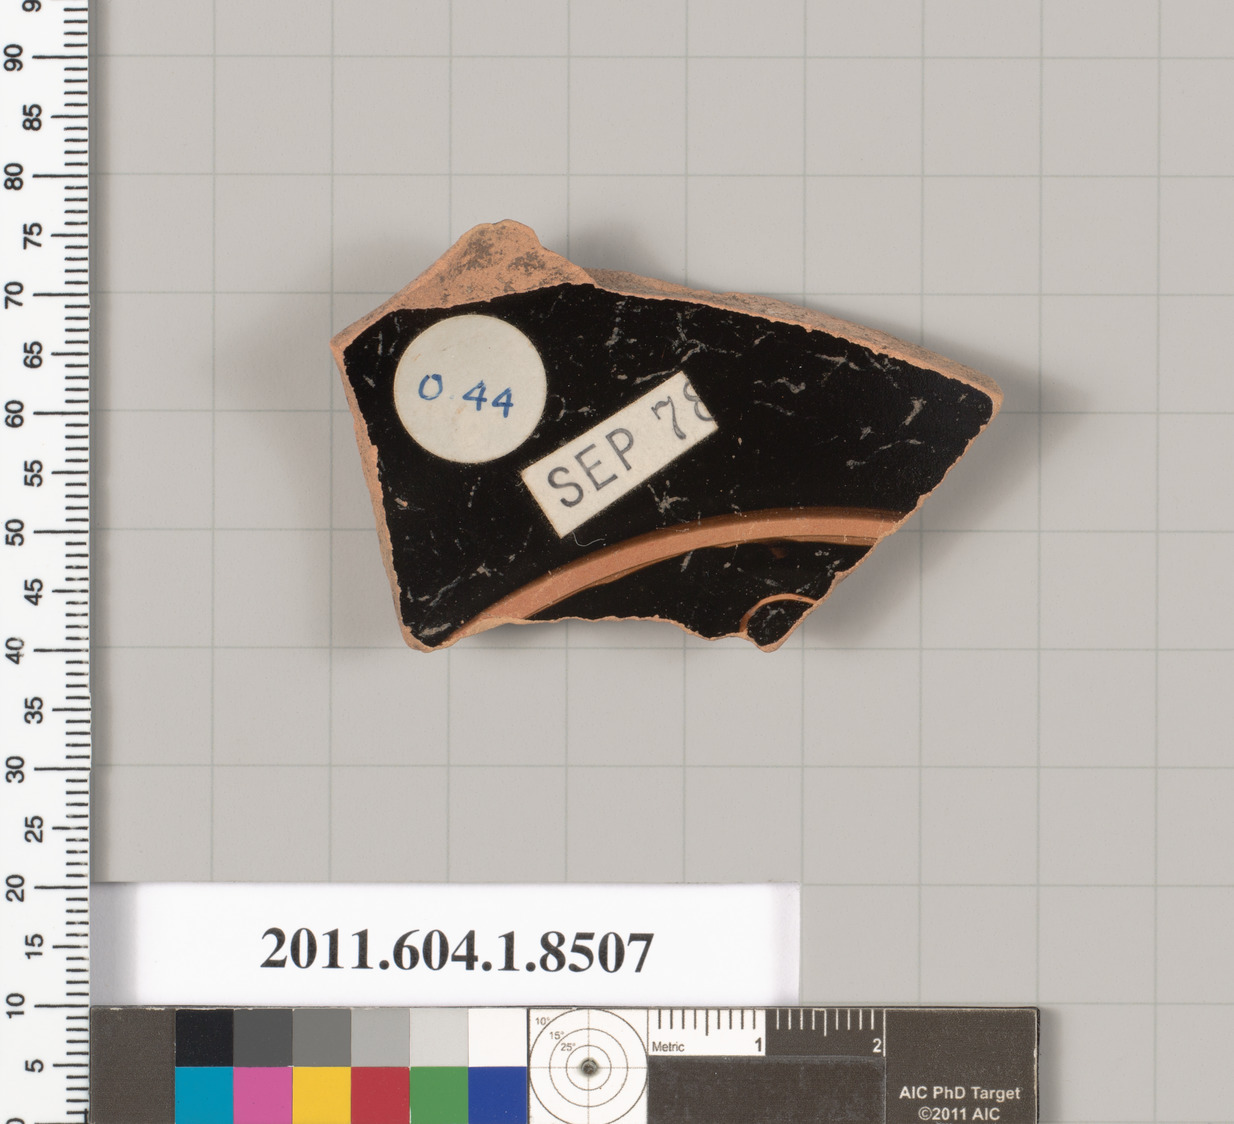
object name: kylix fragment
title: Terracotta fragment of a stemless kylix (drinking cup)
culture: greek, attic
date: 470-450 BCE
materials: terracotta